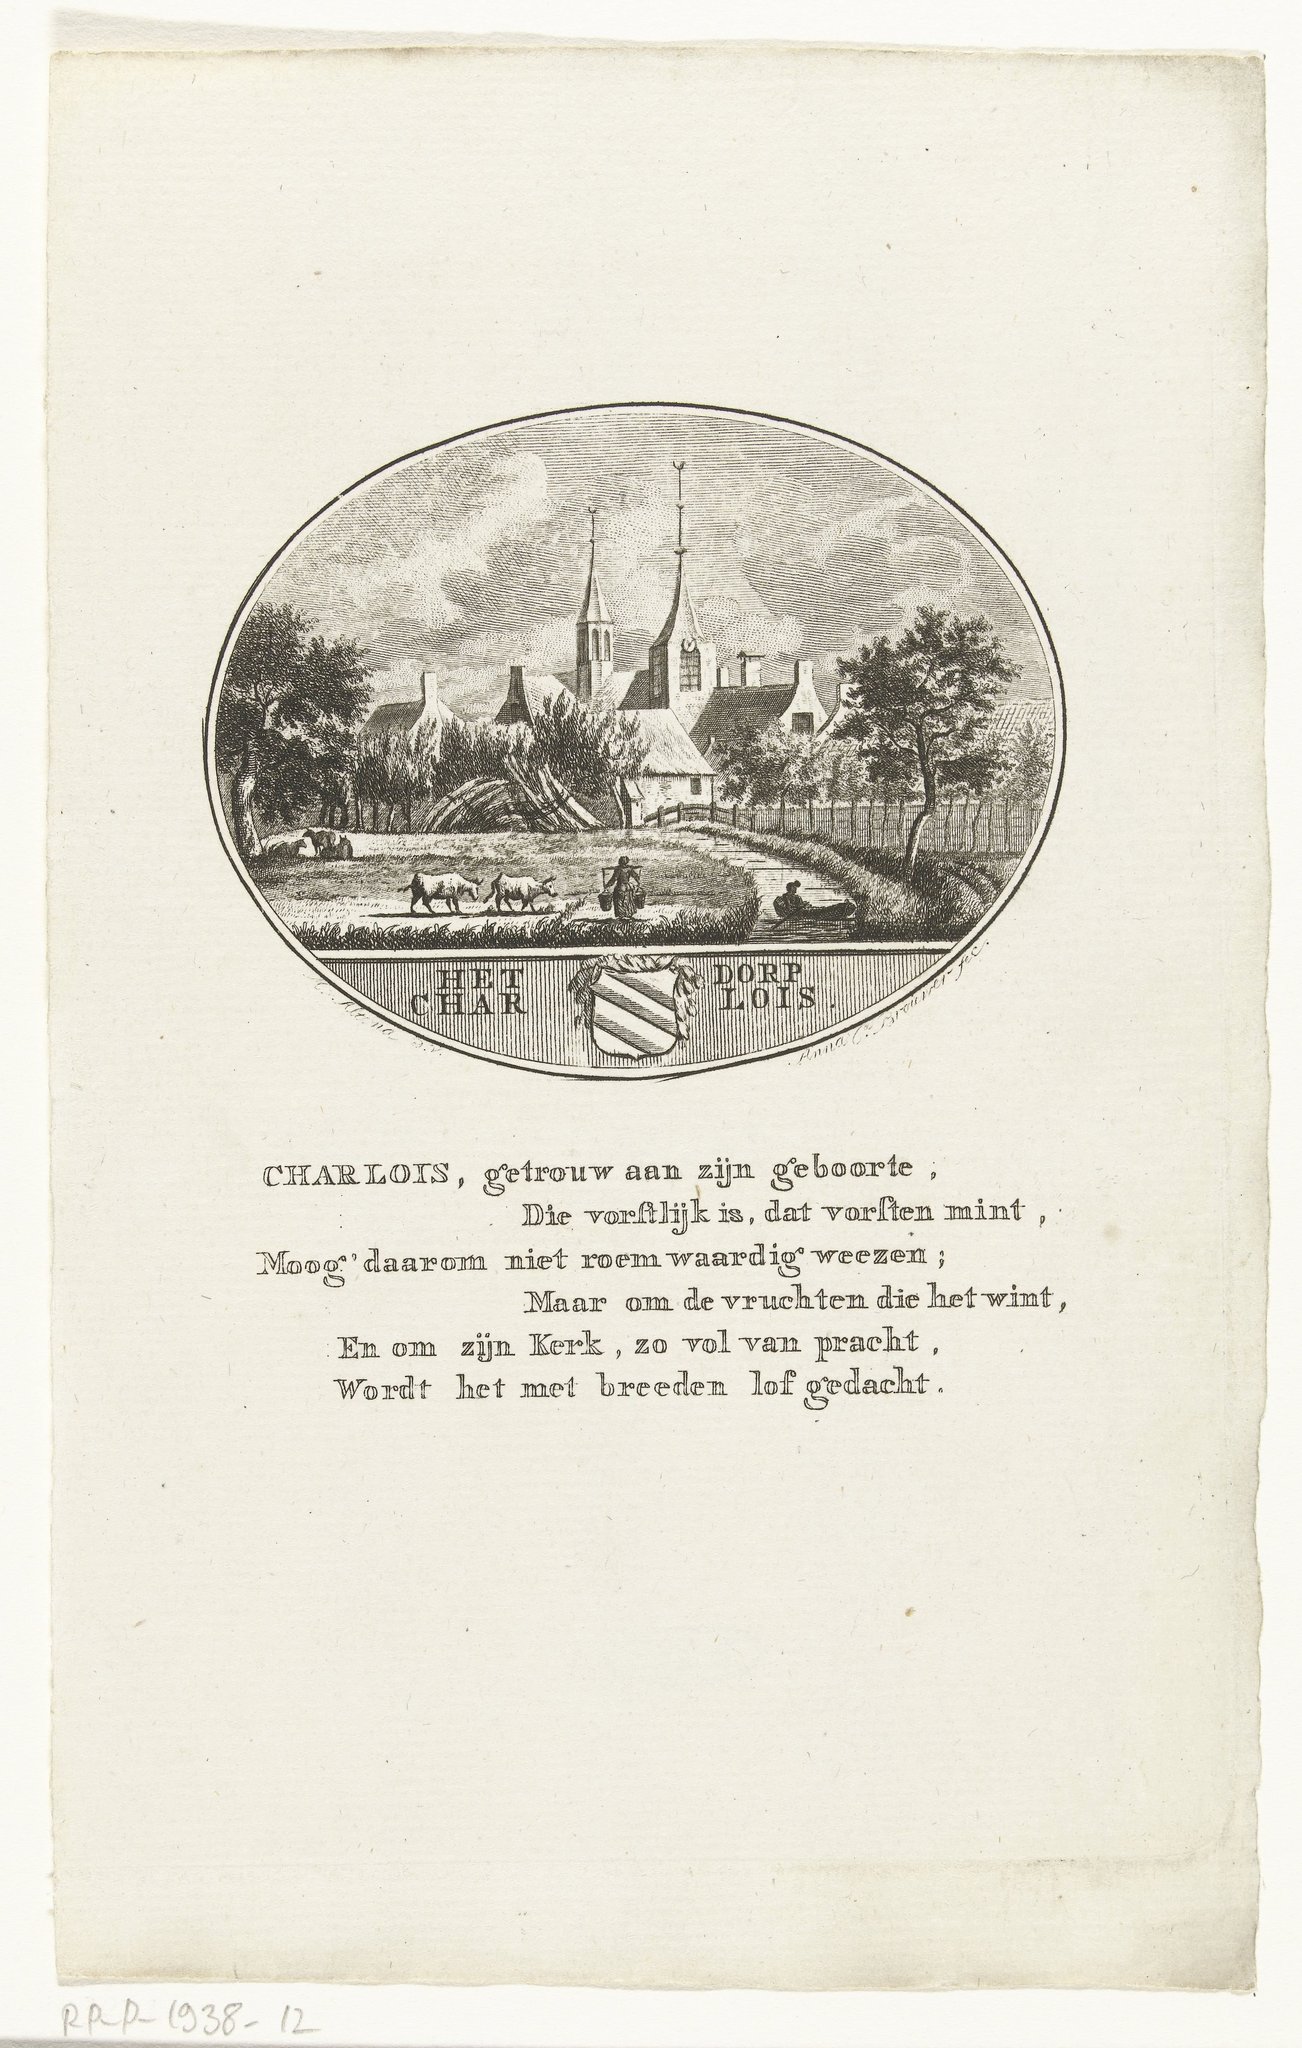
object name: book illustration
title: Het dorp Charlois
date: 1791-1793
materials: paper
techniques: etching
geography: amsterdam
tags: city-view in general; 'veduta'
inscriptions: collector's mark: Lugt 2228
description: afkomstig uit: L. van Ollefen, De Nederlandsche stad- en dorp-beschrijver. Deel 1, Amsterdam: Hendrik Arend Banse, 1793.